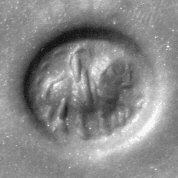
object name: stamp seal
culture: sasanian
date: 201-700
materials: stone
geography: iran or mesopotamia